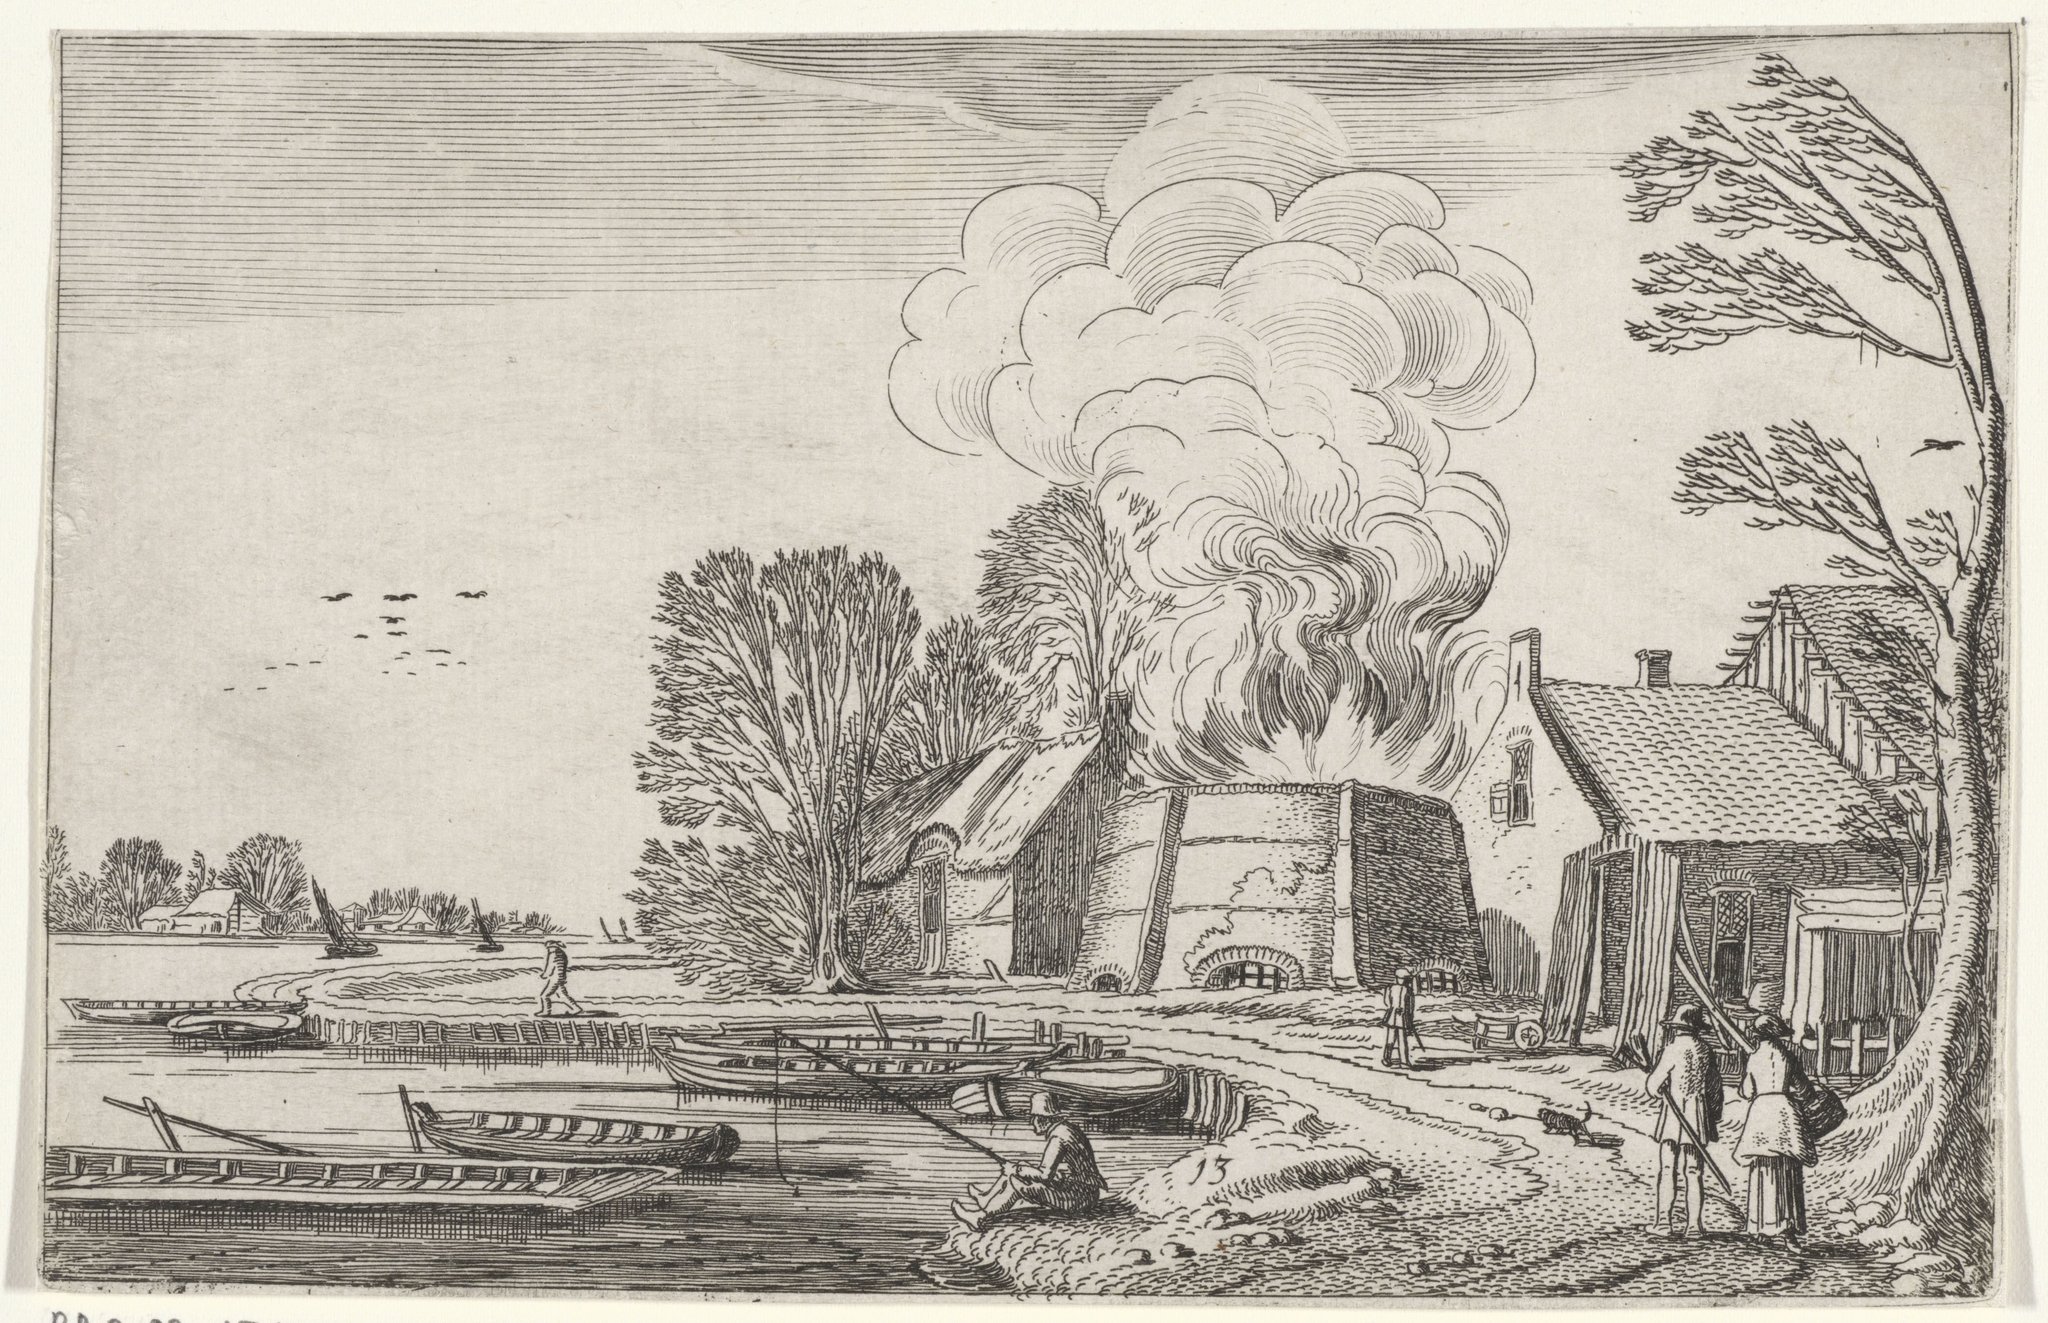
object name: print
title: Figuren bij een kalkoven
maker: jan van de velde (ii)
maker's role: draughtsman, painter, print maker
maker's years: 1593-1641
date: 1616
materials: paper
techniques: etching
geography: northern netherlands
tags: lime works, angling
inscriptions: collector's mark: Lugt 964, collector's mark: Lugt 698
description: Een rookwolk stijgt op uit een brandende kalkoven. Links een rivier met roeibootjes en een hengelaar. Dertiende prent uit een serie van zestien.